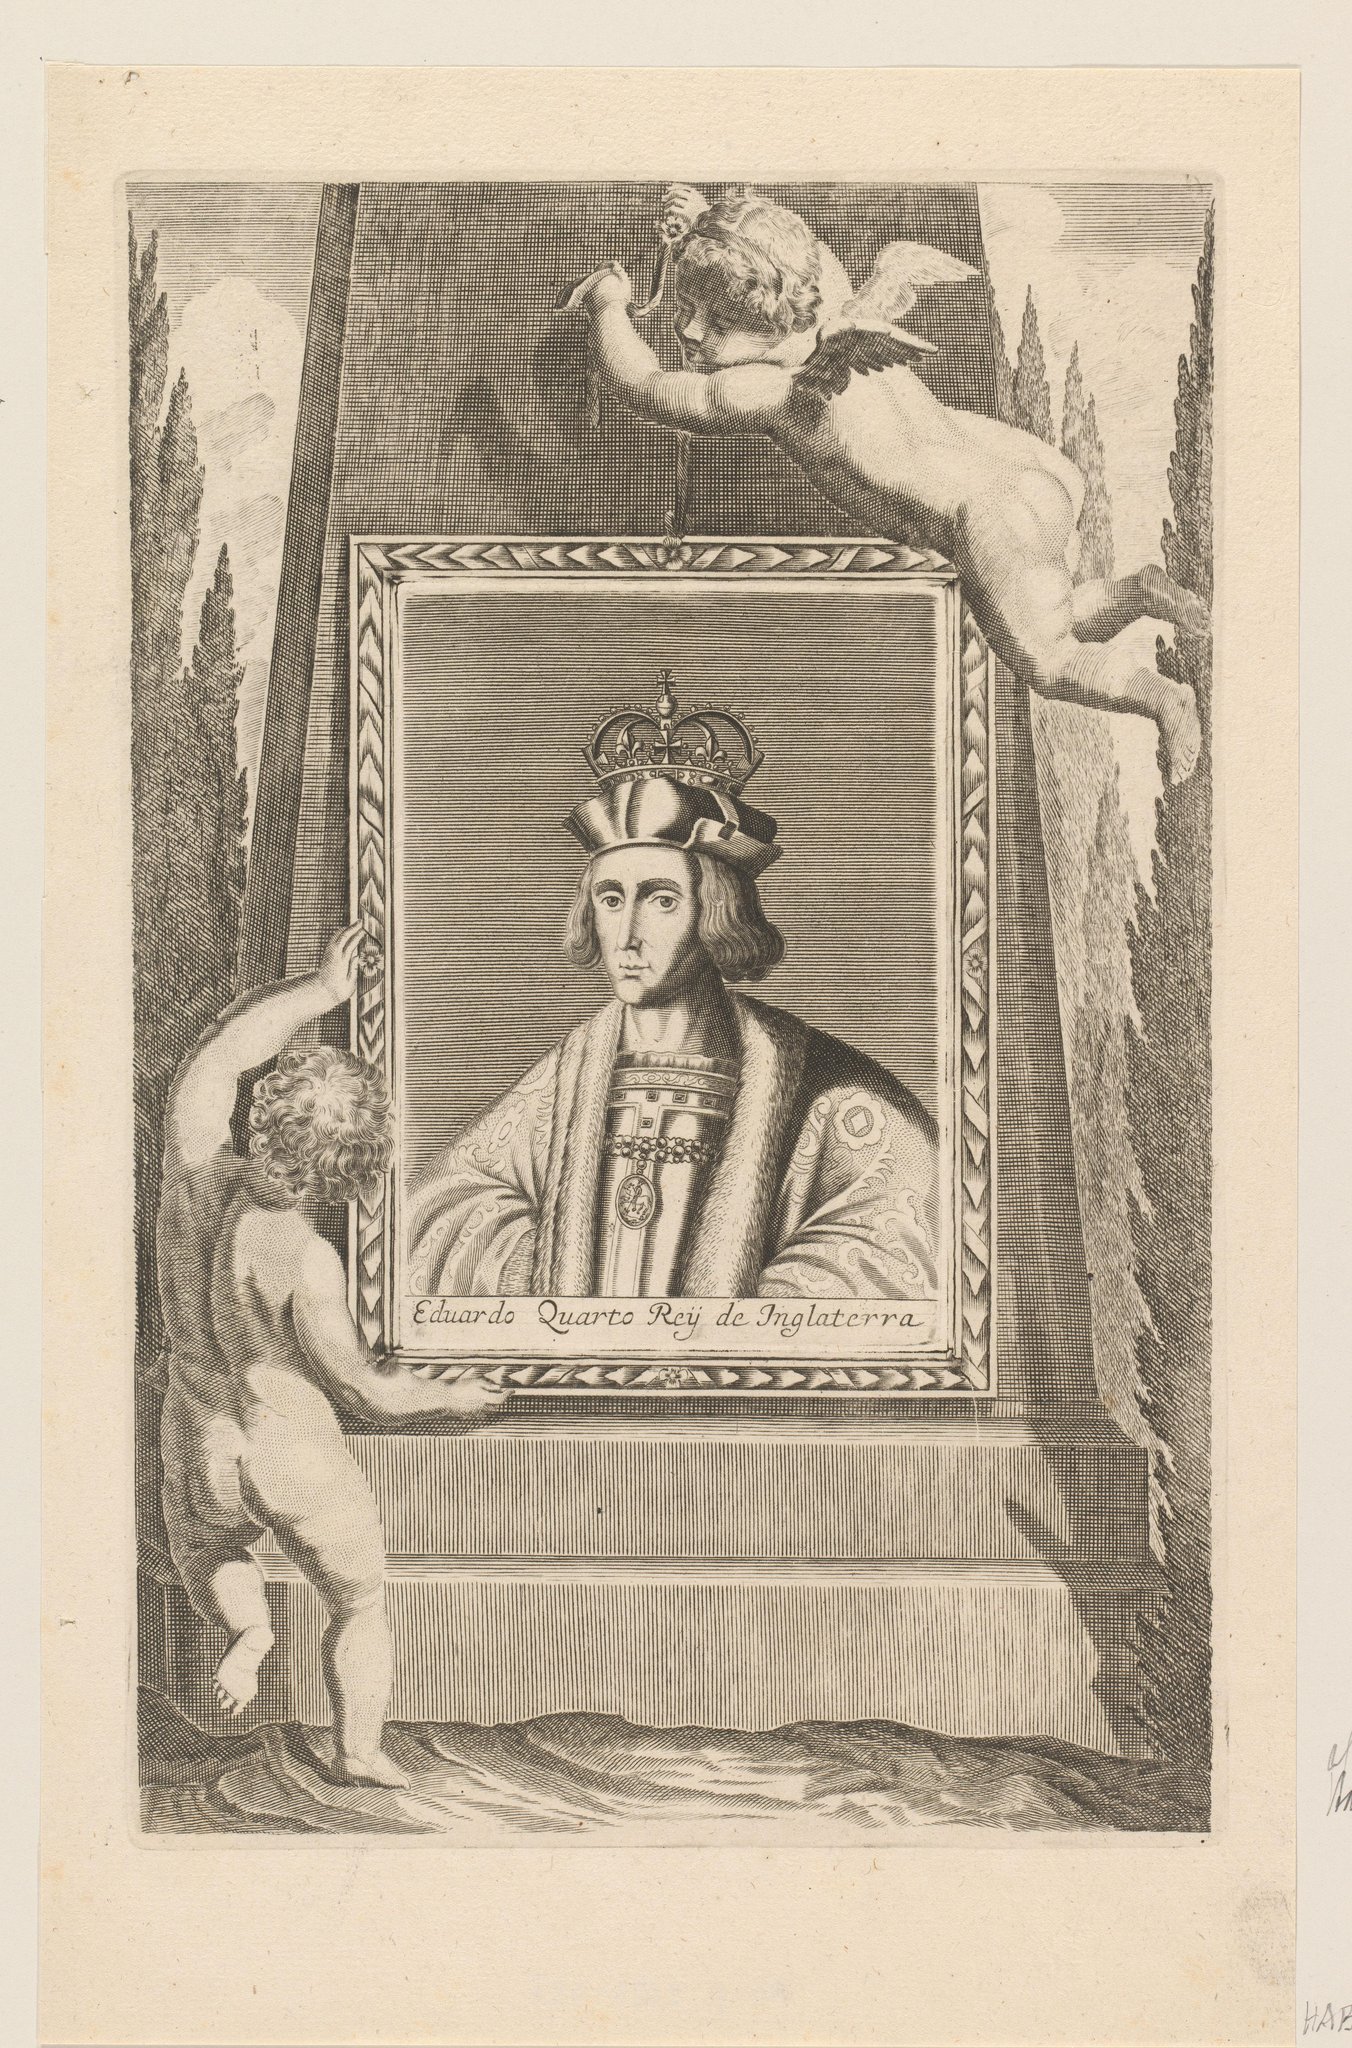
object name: print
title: Portret van Eduard VI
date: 1713-1714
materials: paper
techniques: engraving, etching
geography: low countries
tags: london, historical persons, king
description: Prent waarschijnlijk uit: Komen, Filips van. Las Memorias (...). Antwerpen: Hendrik en Cornelis Verdussen, 1713, dl. 1. Of uit de editie uit 1714.